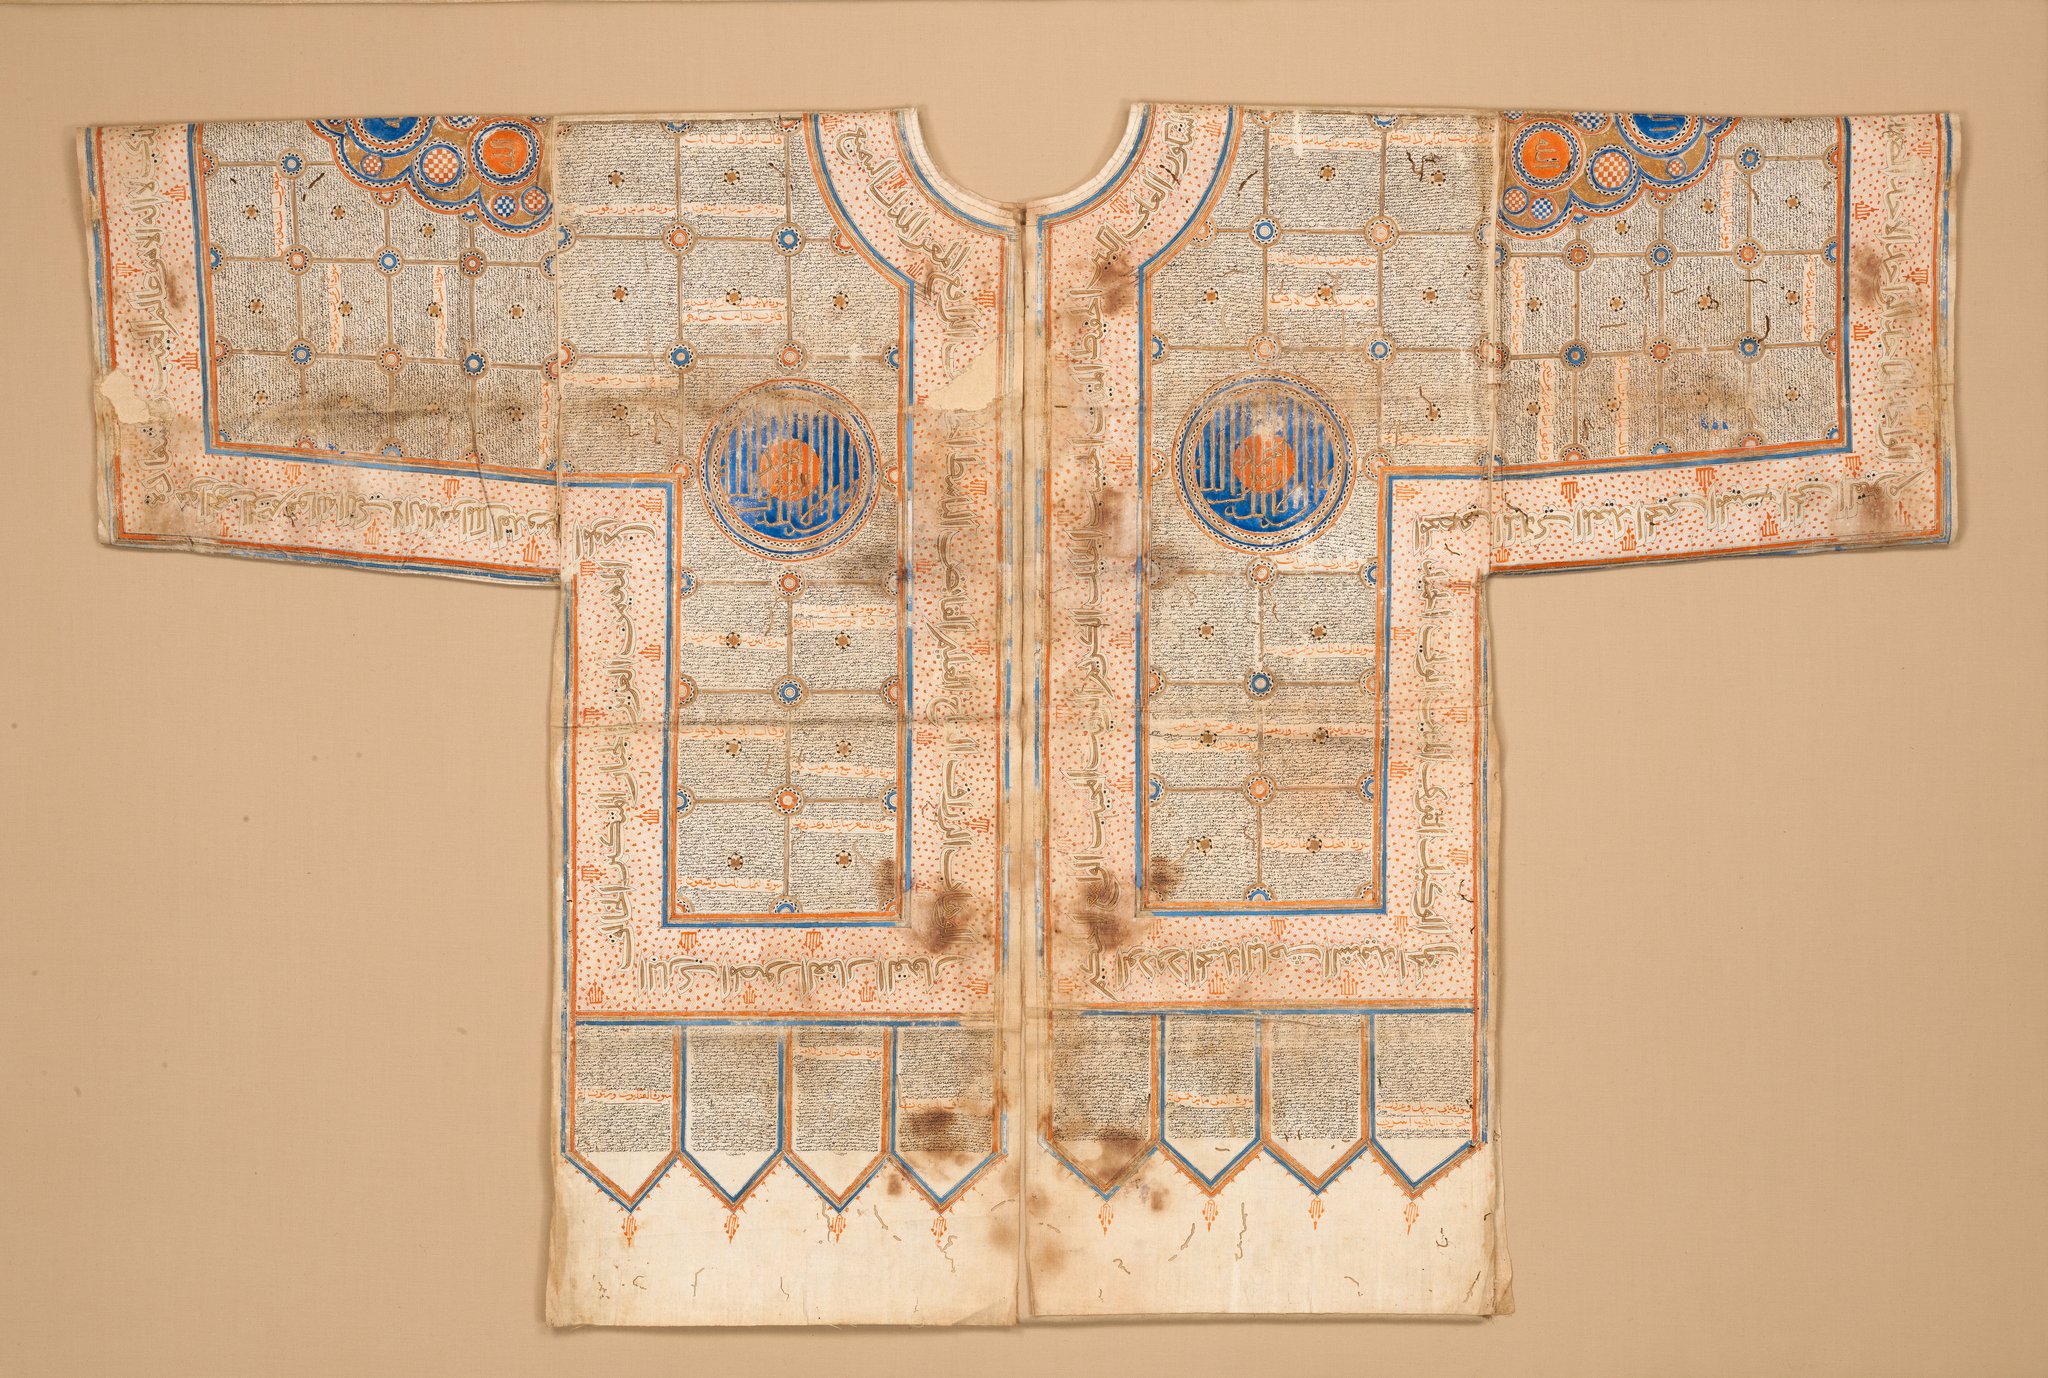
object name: shirt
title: Talismanic Shirt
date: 1401-1533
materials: cotton, gold, ink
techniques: painting, weave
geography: india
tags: qur'an